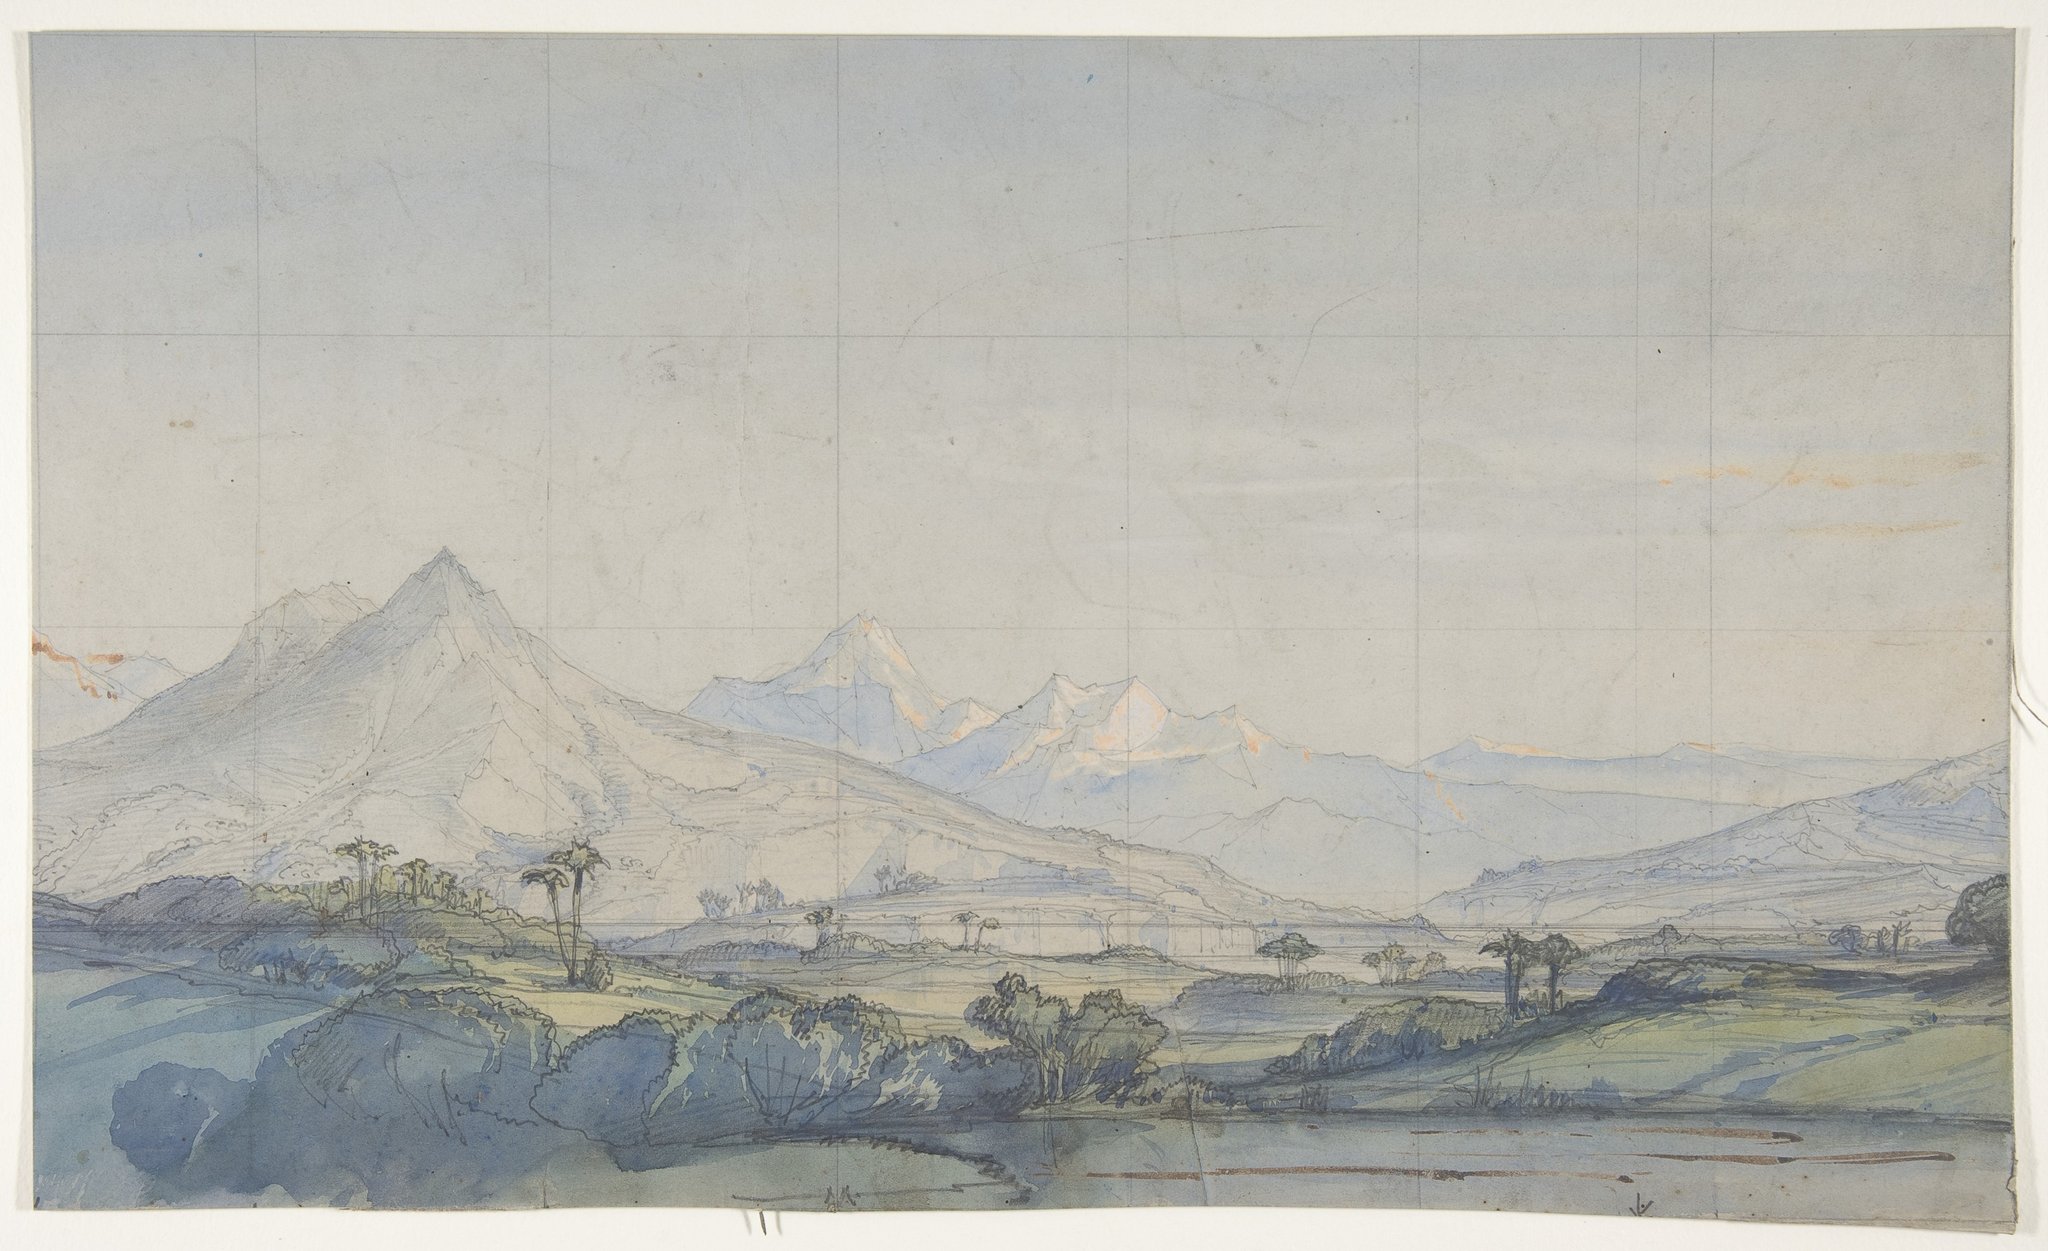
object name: drawing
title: Design for a Stage Set at the Opéra, Paris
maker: eugène cicéri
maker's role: artist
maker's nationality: french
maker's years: 1813-1890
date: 1828-1890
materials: graphite, watercolor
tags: mountains,landscapes,stage design